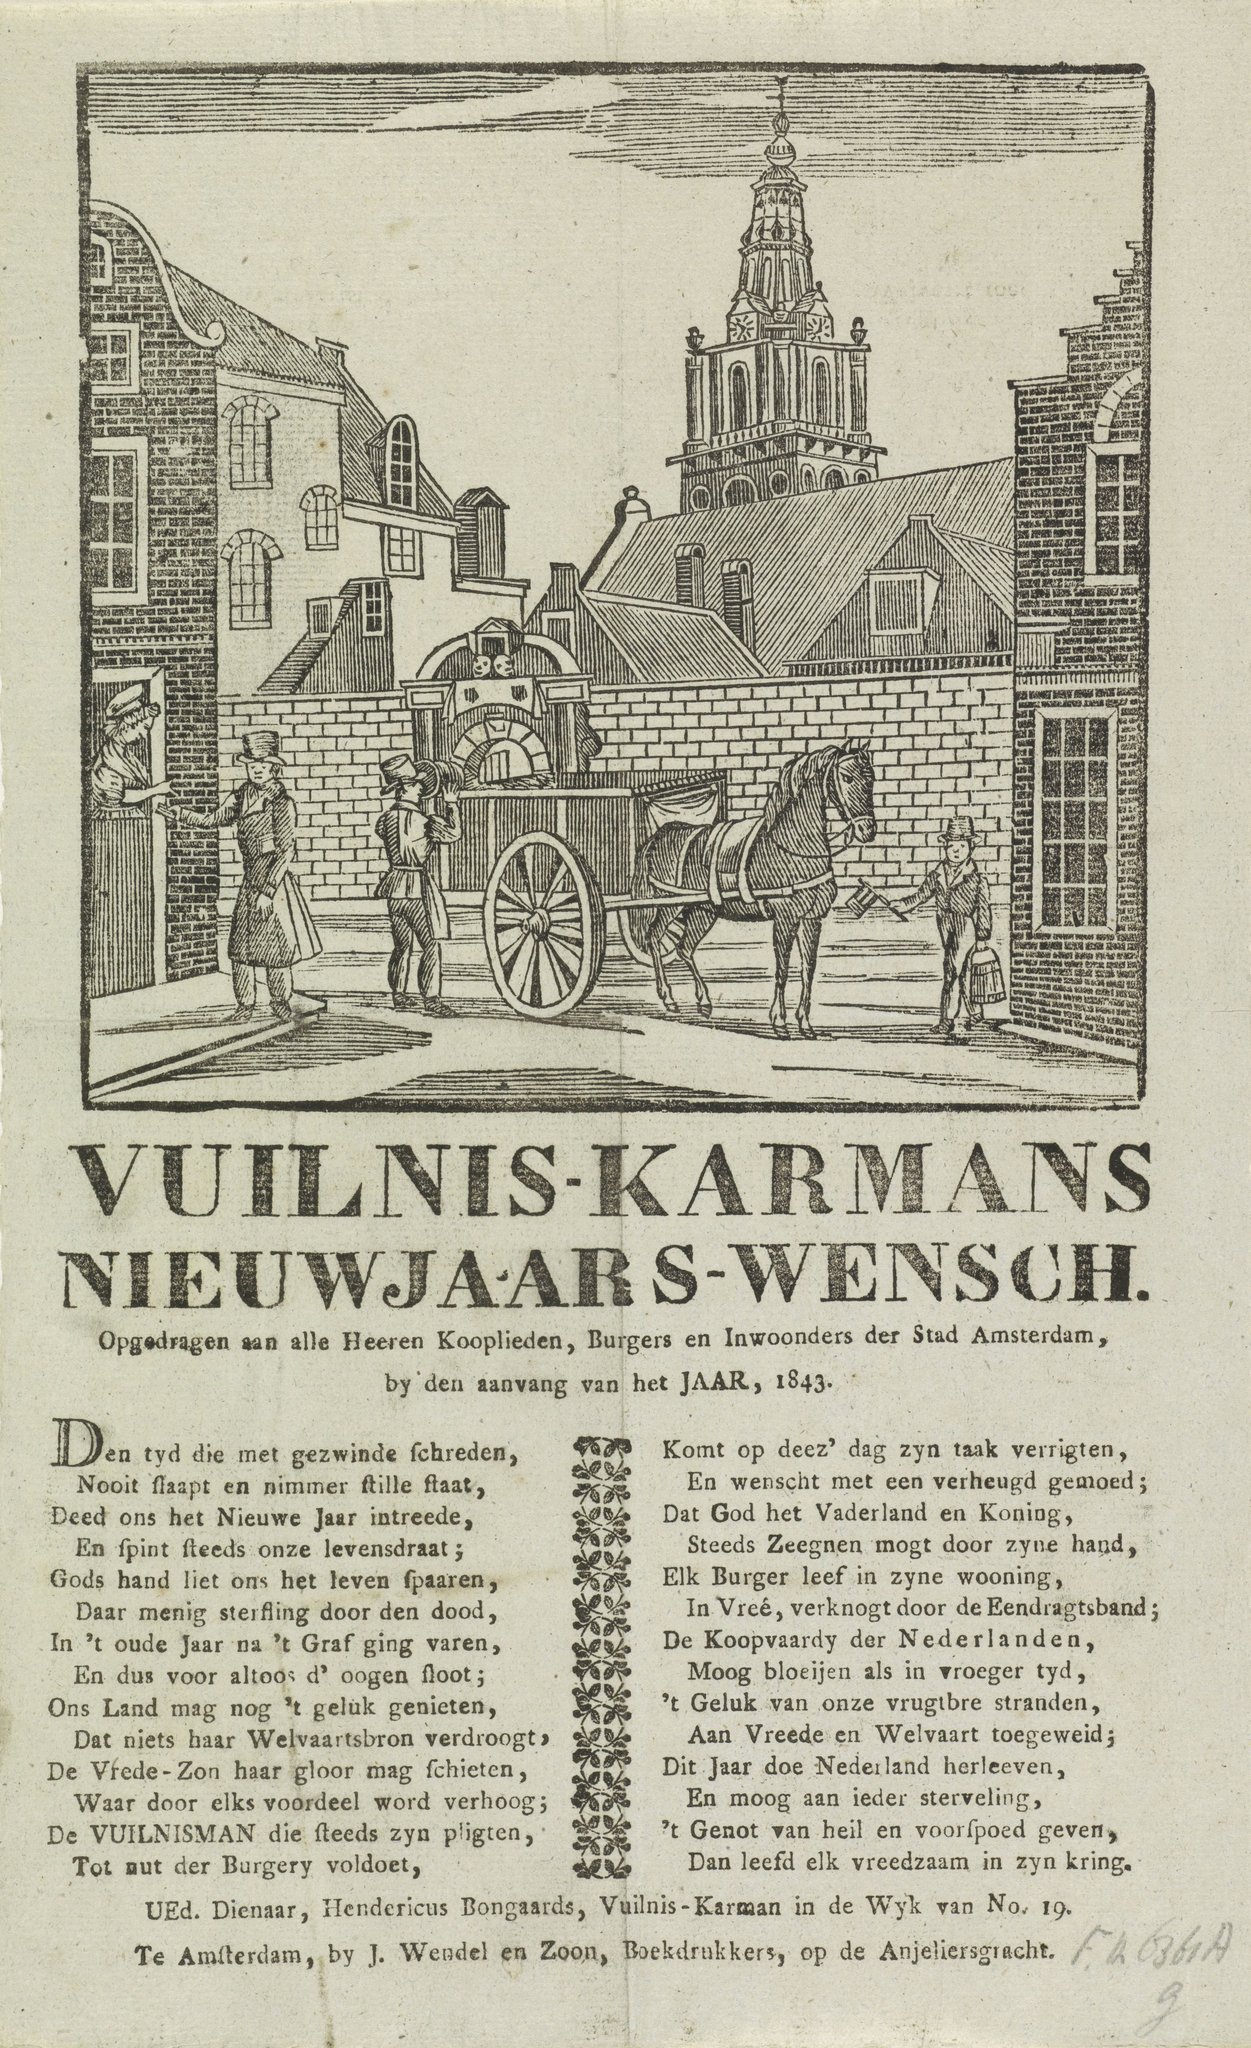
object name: new year card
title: Vuilnis-karmans nieuwjaars-wensch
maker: Anonymous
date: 1842-1843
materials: paper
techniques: letterpress printing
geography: amsterdam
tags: street, garbage collection, amsterdam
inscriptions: collector's mark: Lugt 2228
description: Nieuwjaarswens van de Amsterdamse vuilnismannen voor het jaar 1843. Gezicht bij de Sint-Antoniesbreestraat en het poortje naar de Zuiderkerkhof bij Zuiderkerk te Amsterdam, waar een man een vuilnisemmer in de kar leegkiepert en een andere man met de ratel draait. Een andere man haalt bij een huis geld op. Met gedicht in twee kolommen. Van de vuilniskarman in de wijk no. 19: Hendericus Bongaards.